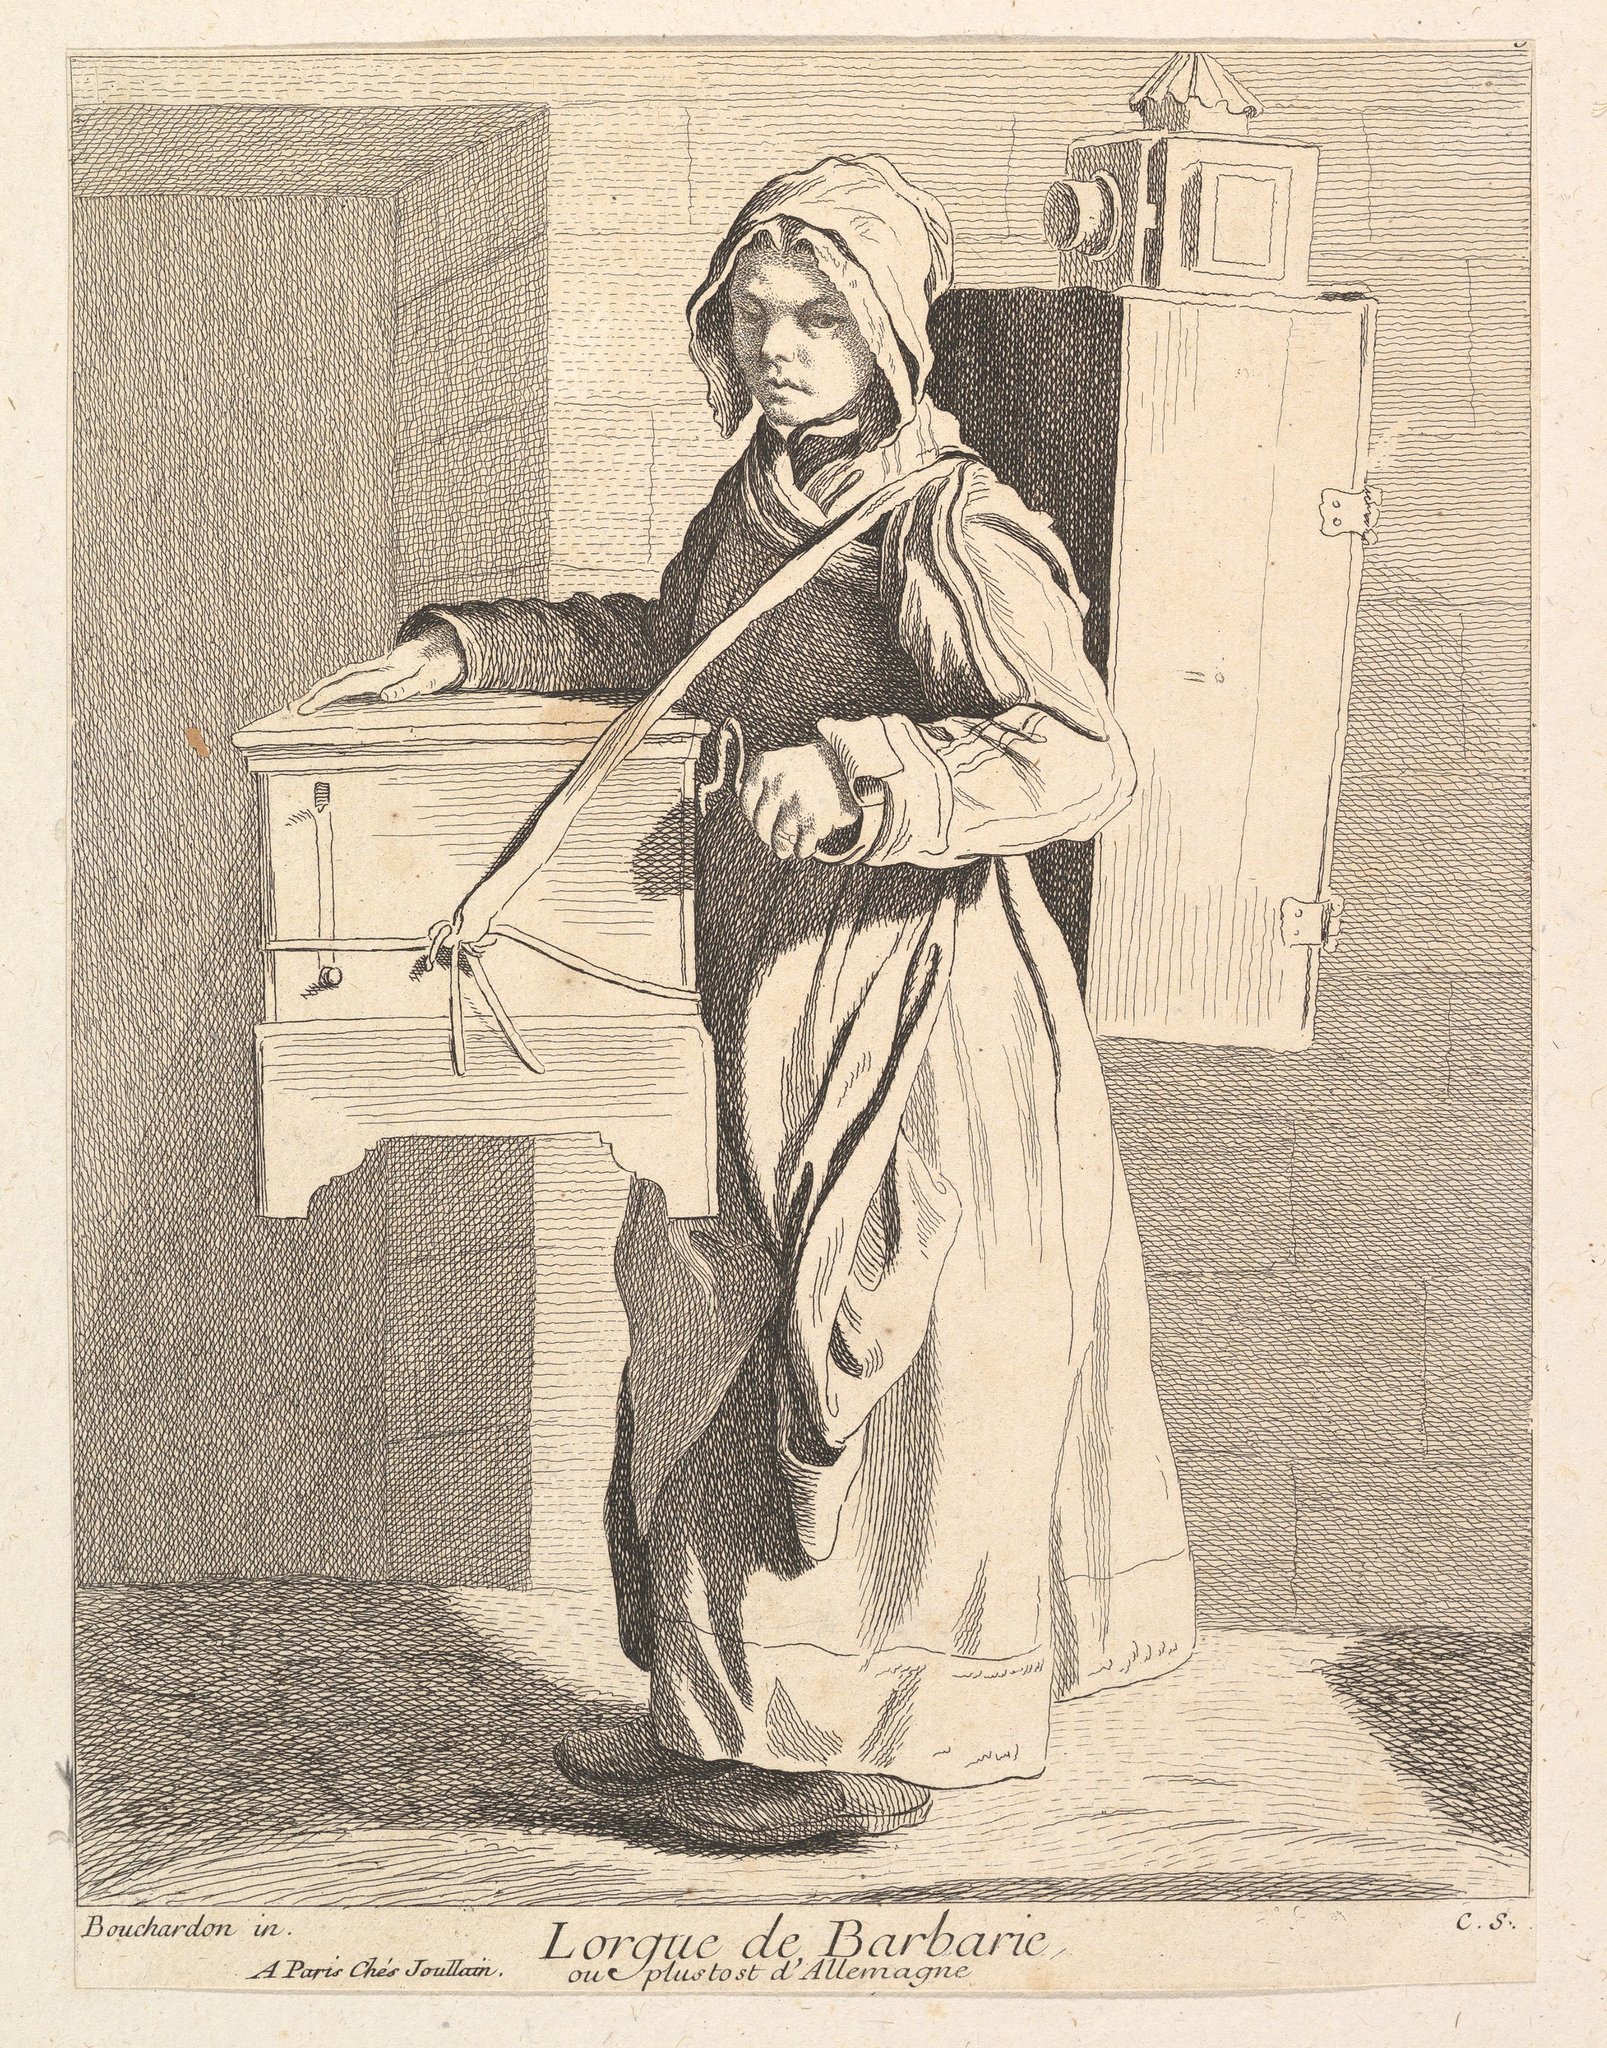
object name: print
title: Organ Grinder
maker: anne claude philippe de tubières, comte de caylus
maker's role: artist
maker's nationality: french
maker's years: 1692-1765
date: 1737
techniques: engraving, etching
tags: musical instruments,women